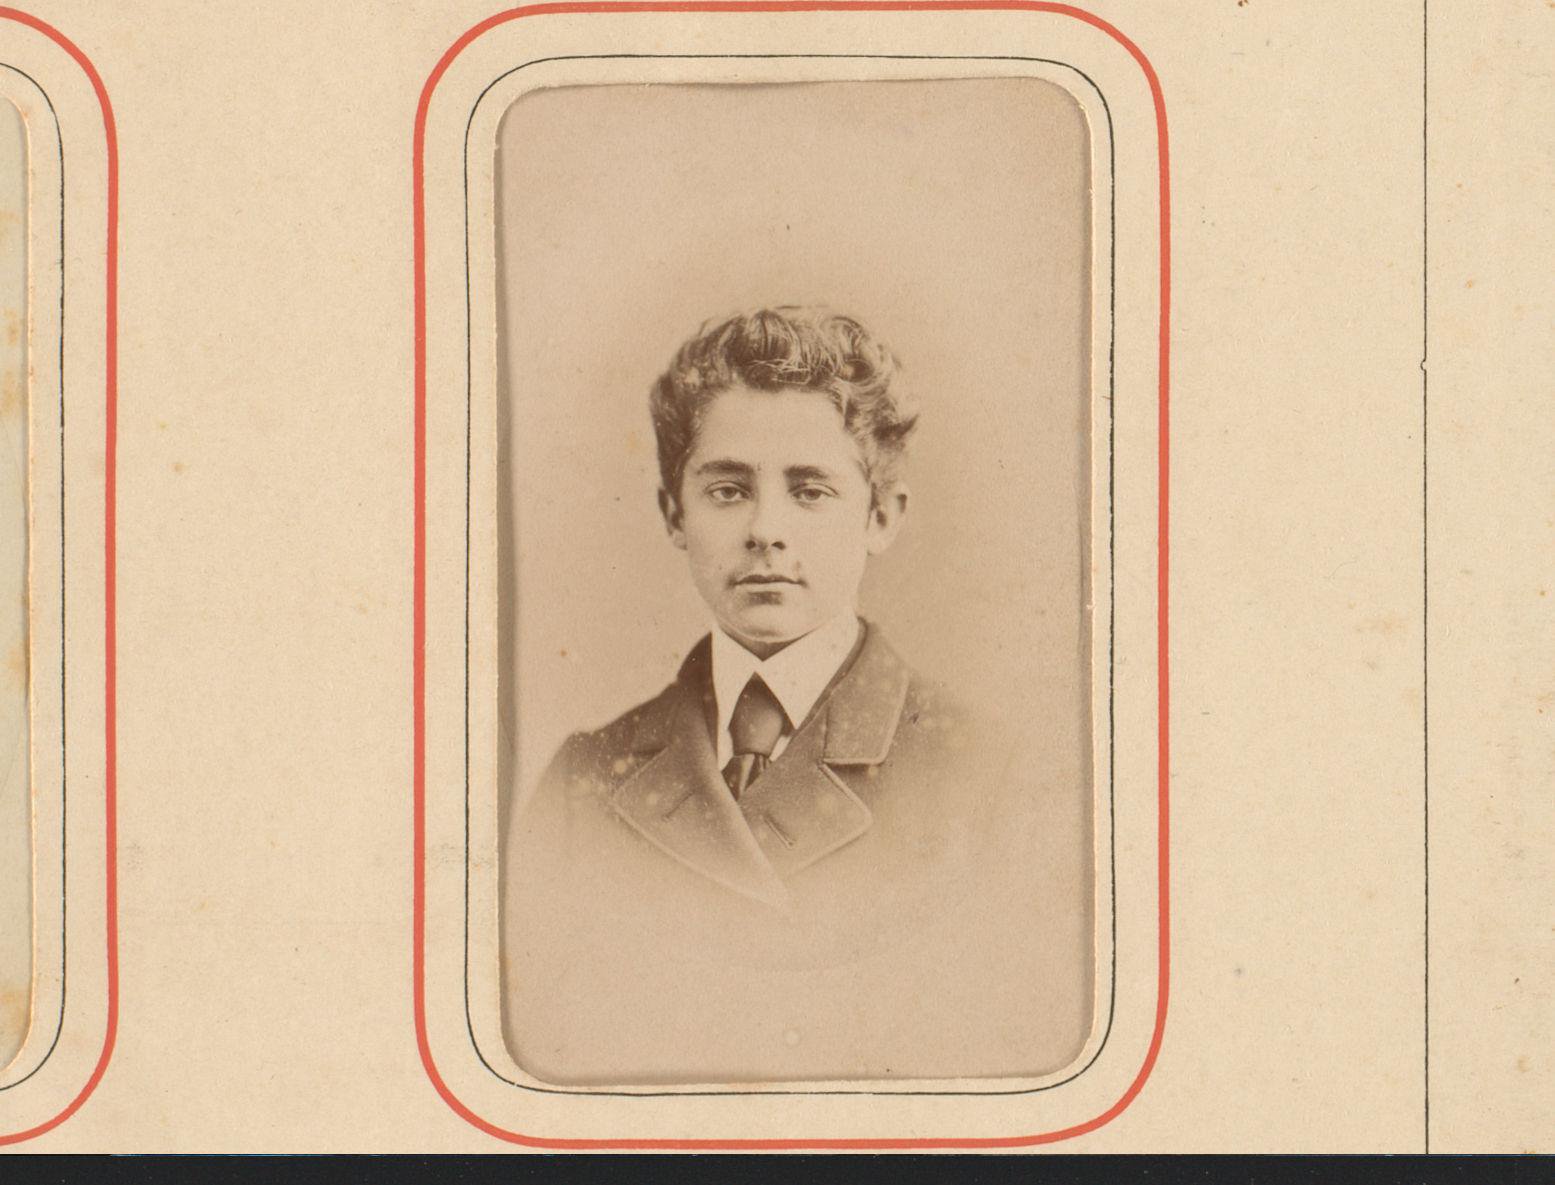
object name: photograph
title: Portret van een onbekende jonge man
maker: maurits verveer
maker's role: painter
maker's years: 1817-1903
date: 1870-1890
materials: cardboard, paper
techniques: albumen print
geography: the hague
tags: anonymous historical person portrayed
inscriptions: address: ‘52. Zeestraat, vis à vis du Willemspark, 52/ LA HAYE’